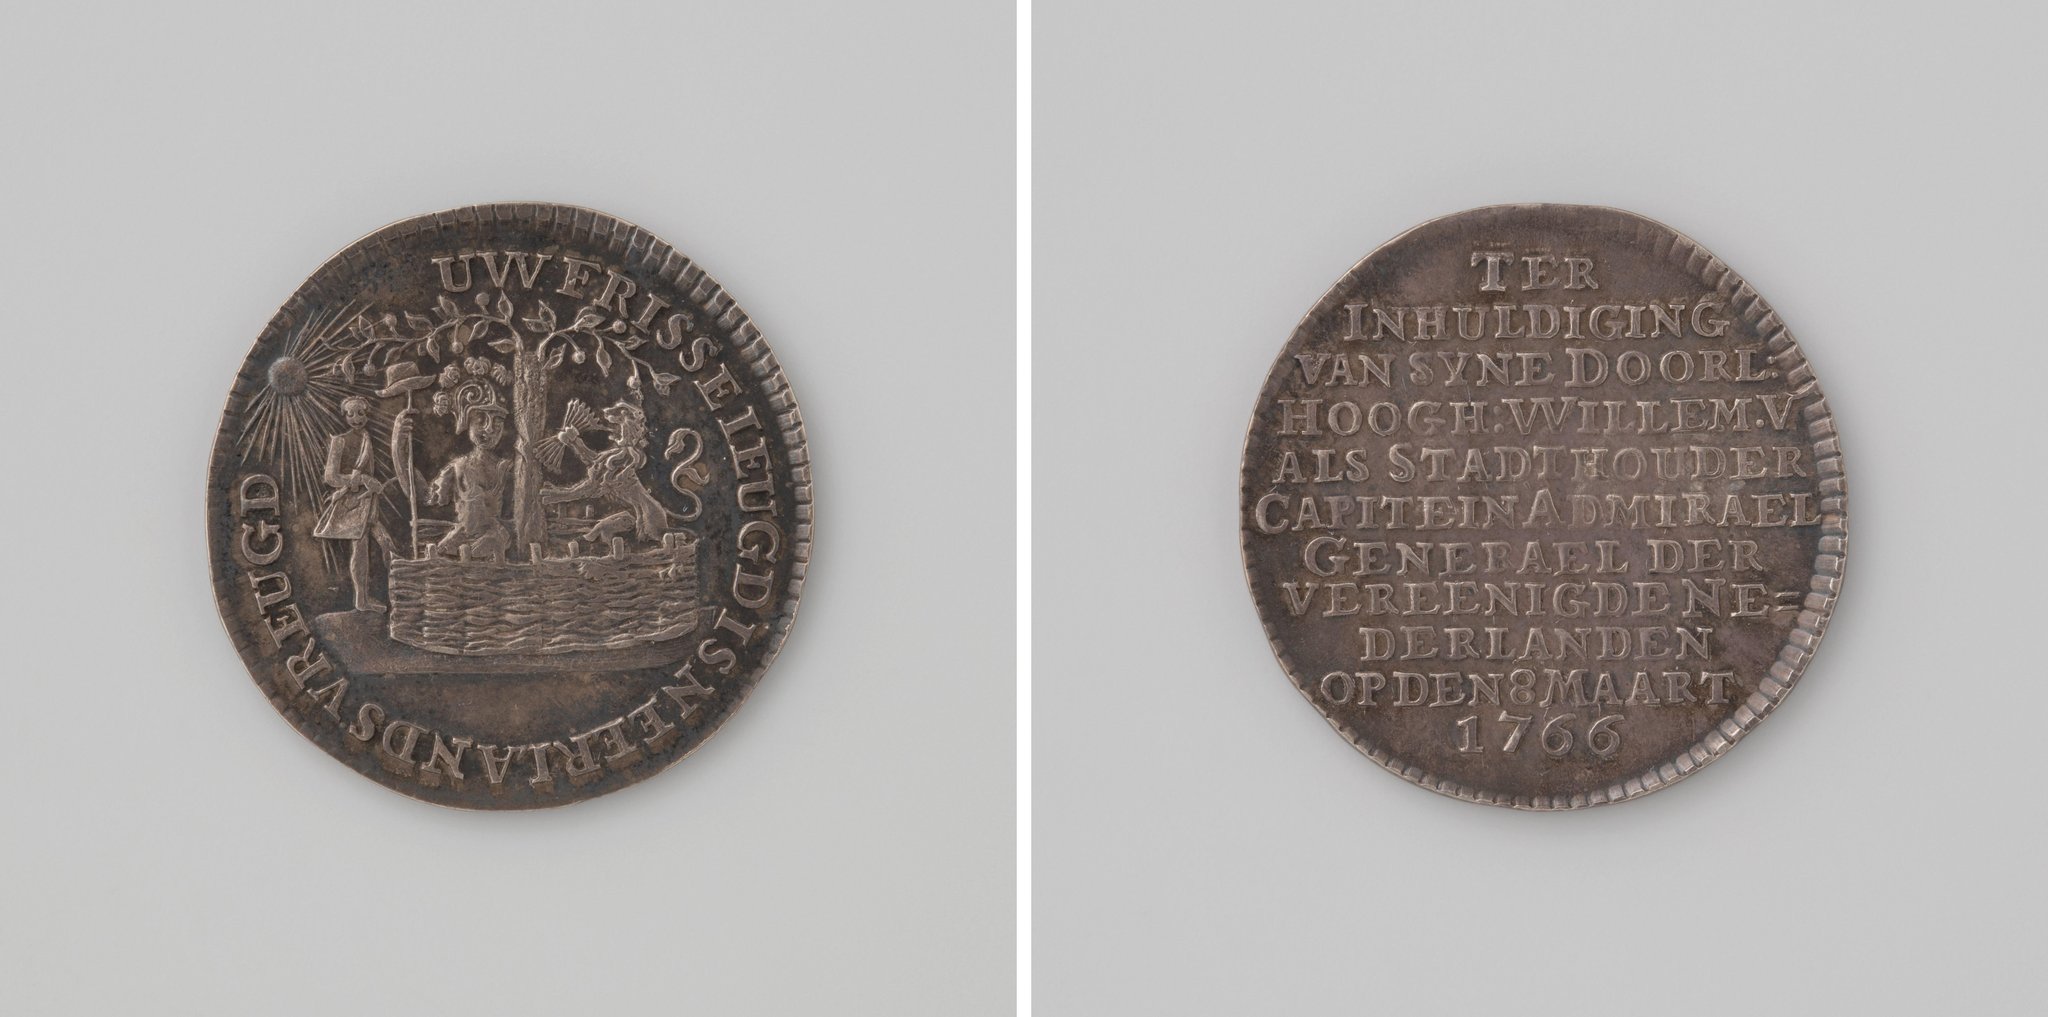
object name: history medal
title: Inhuldiging van Willem V, prins van Oranje-Nassau, als erfelijk stadhouder van de Nederlanden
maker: Anonymous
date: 1766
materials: silver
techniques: striking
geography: netherlands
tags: the hague, william v (prince of orange)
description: Zilveren penning. Voorzijde: Nederlandse maagd met vrijheidshoed op speer en leeuw met pijlenbundel onder takken van oranjeboom in tuin, waarin Willem V binnen treedt binnen omschrift. Keerzijde: opschrift